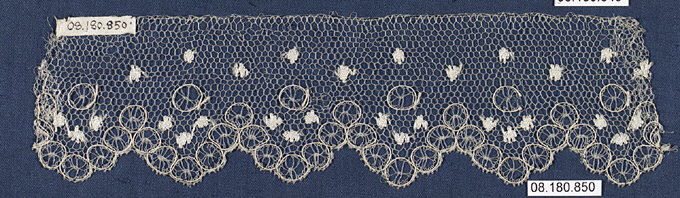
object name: piece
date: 1801-1900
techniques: lace